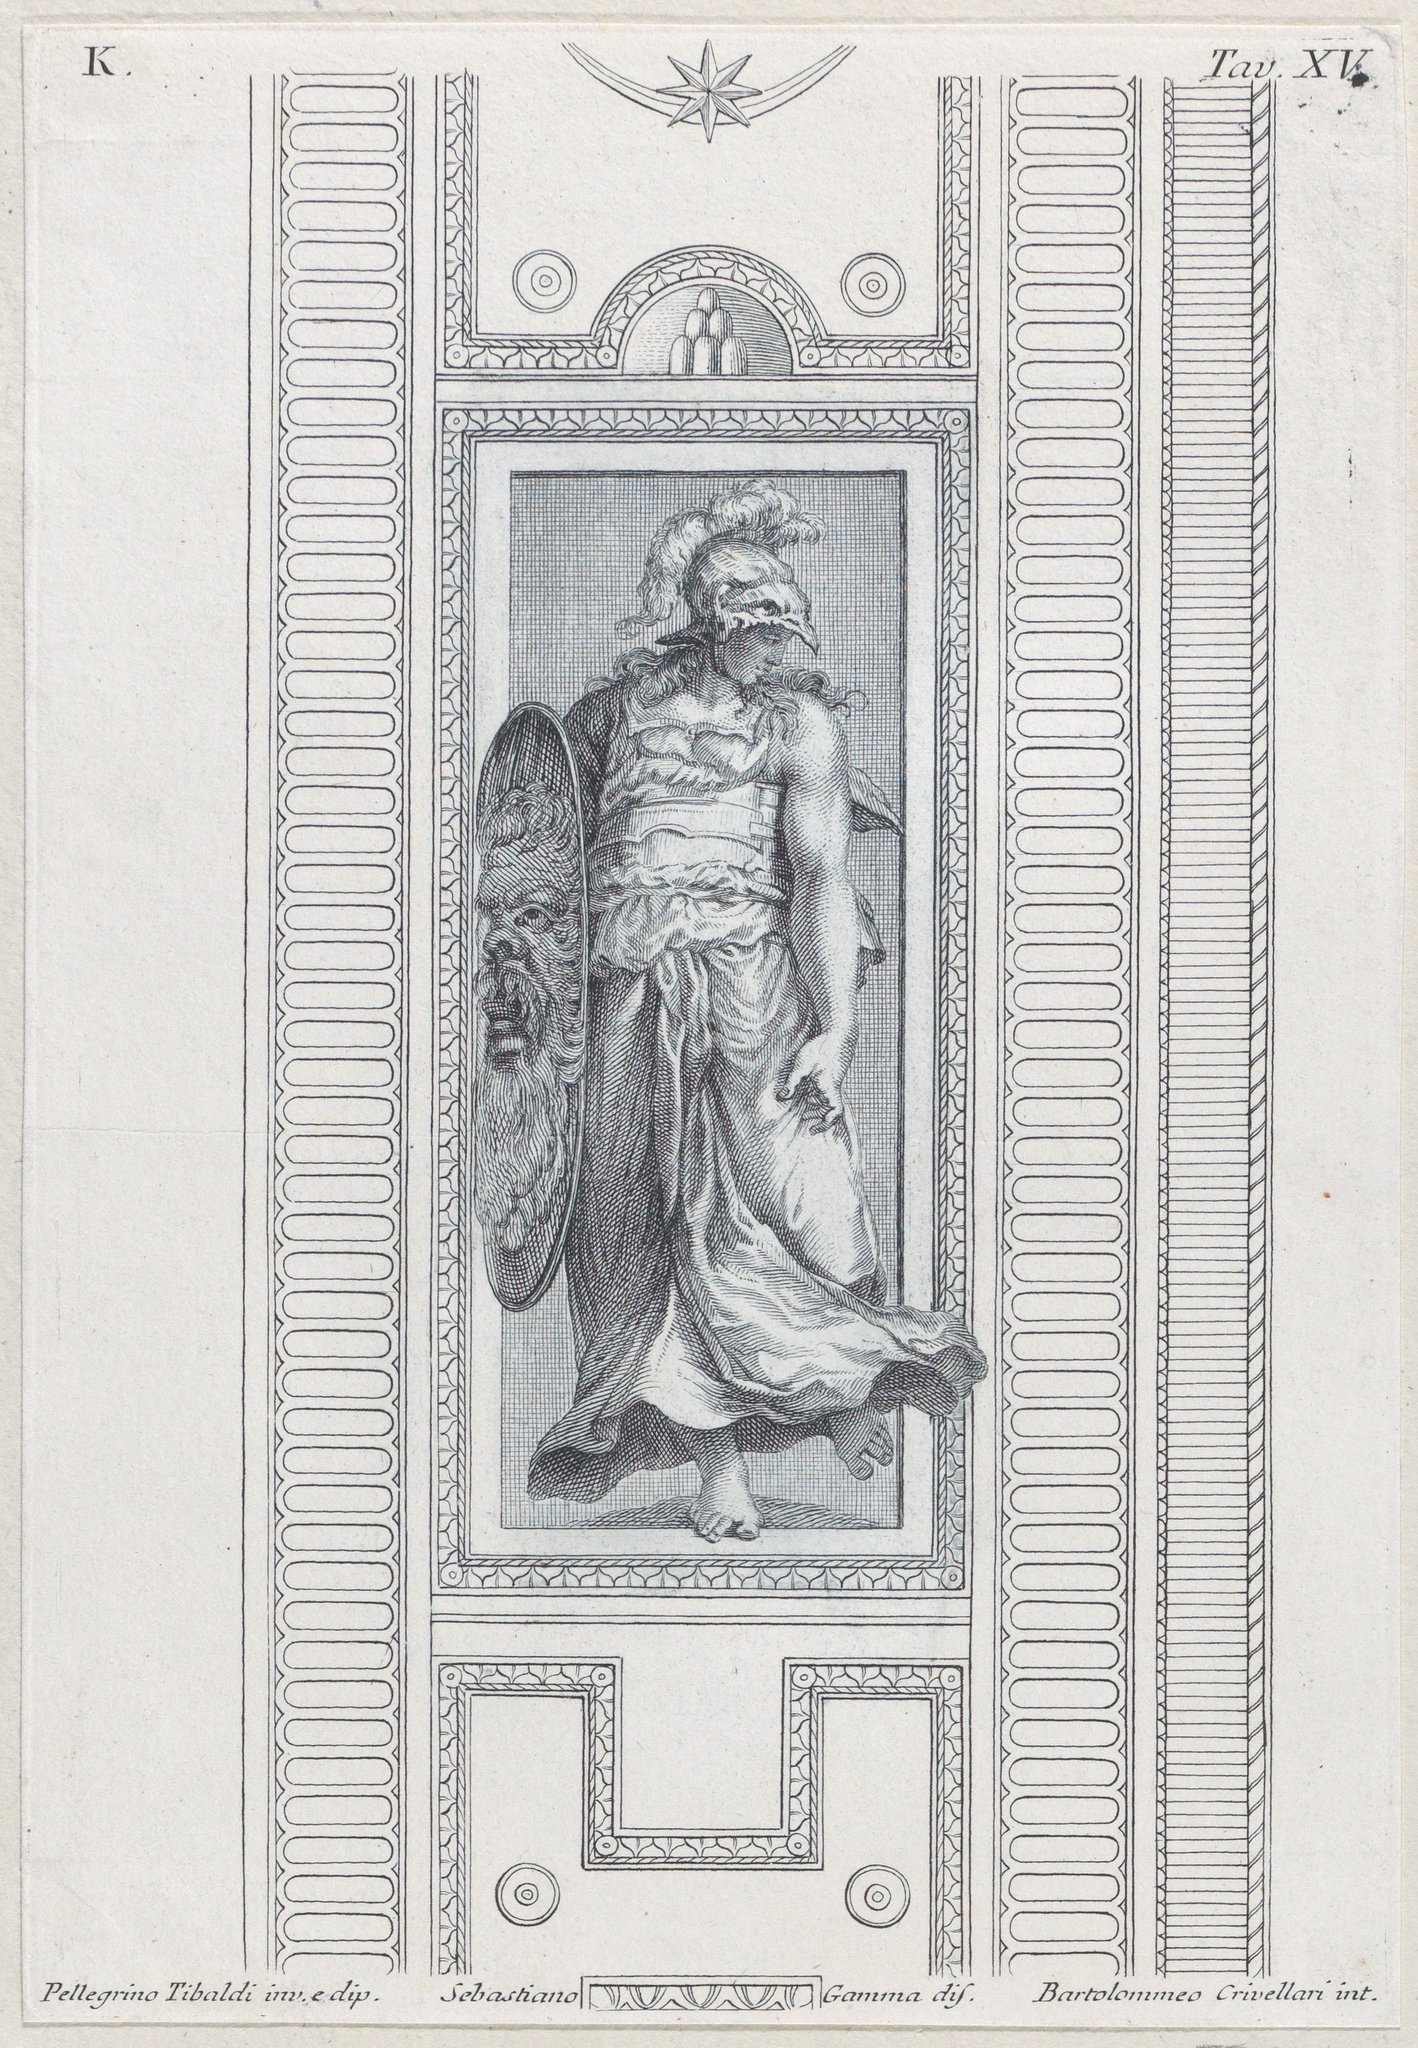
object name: print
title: Plate 15: mythological figure wearing a helmet and holding a shield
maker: bartolomeo crivellari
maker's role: artist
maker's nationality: italian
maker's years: 1700-1800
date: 1756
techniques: engraving, etching